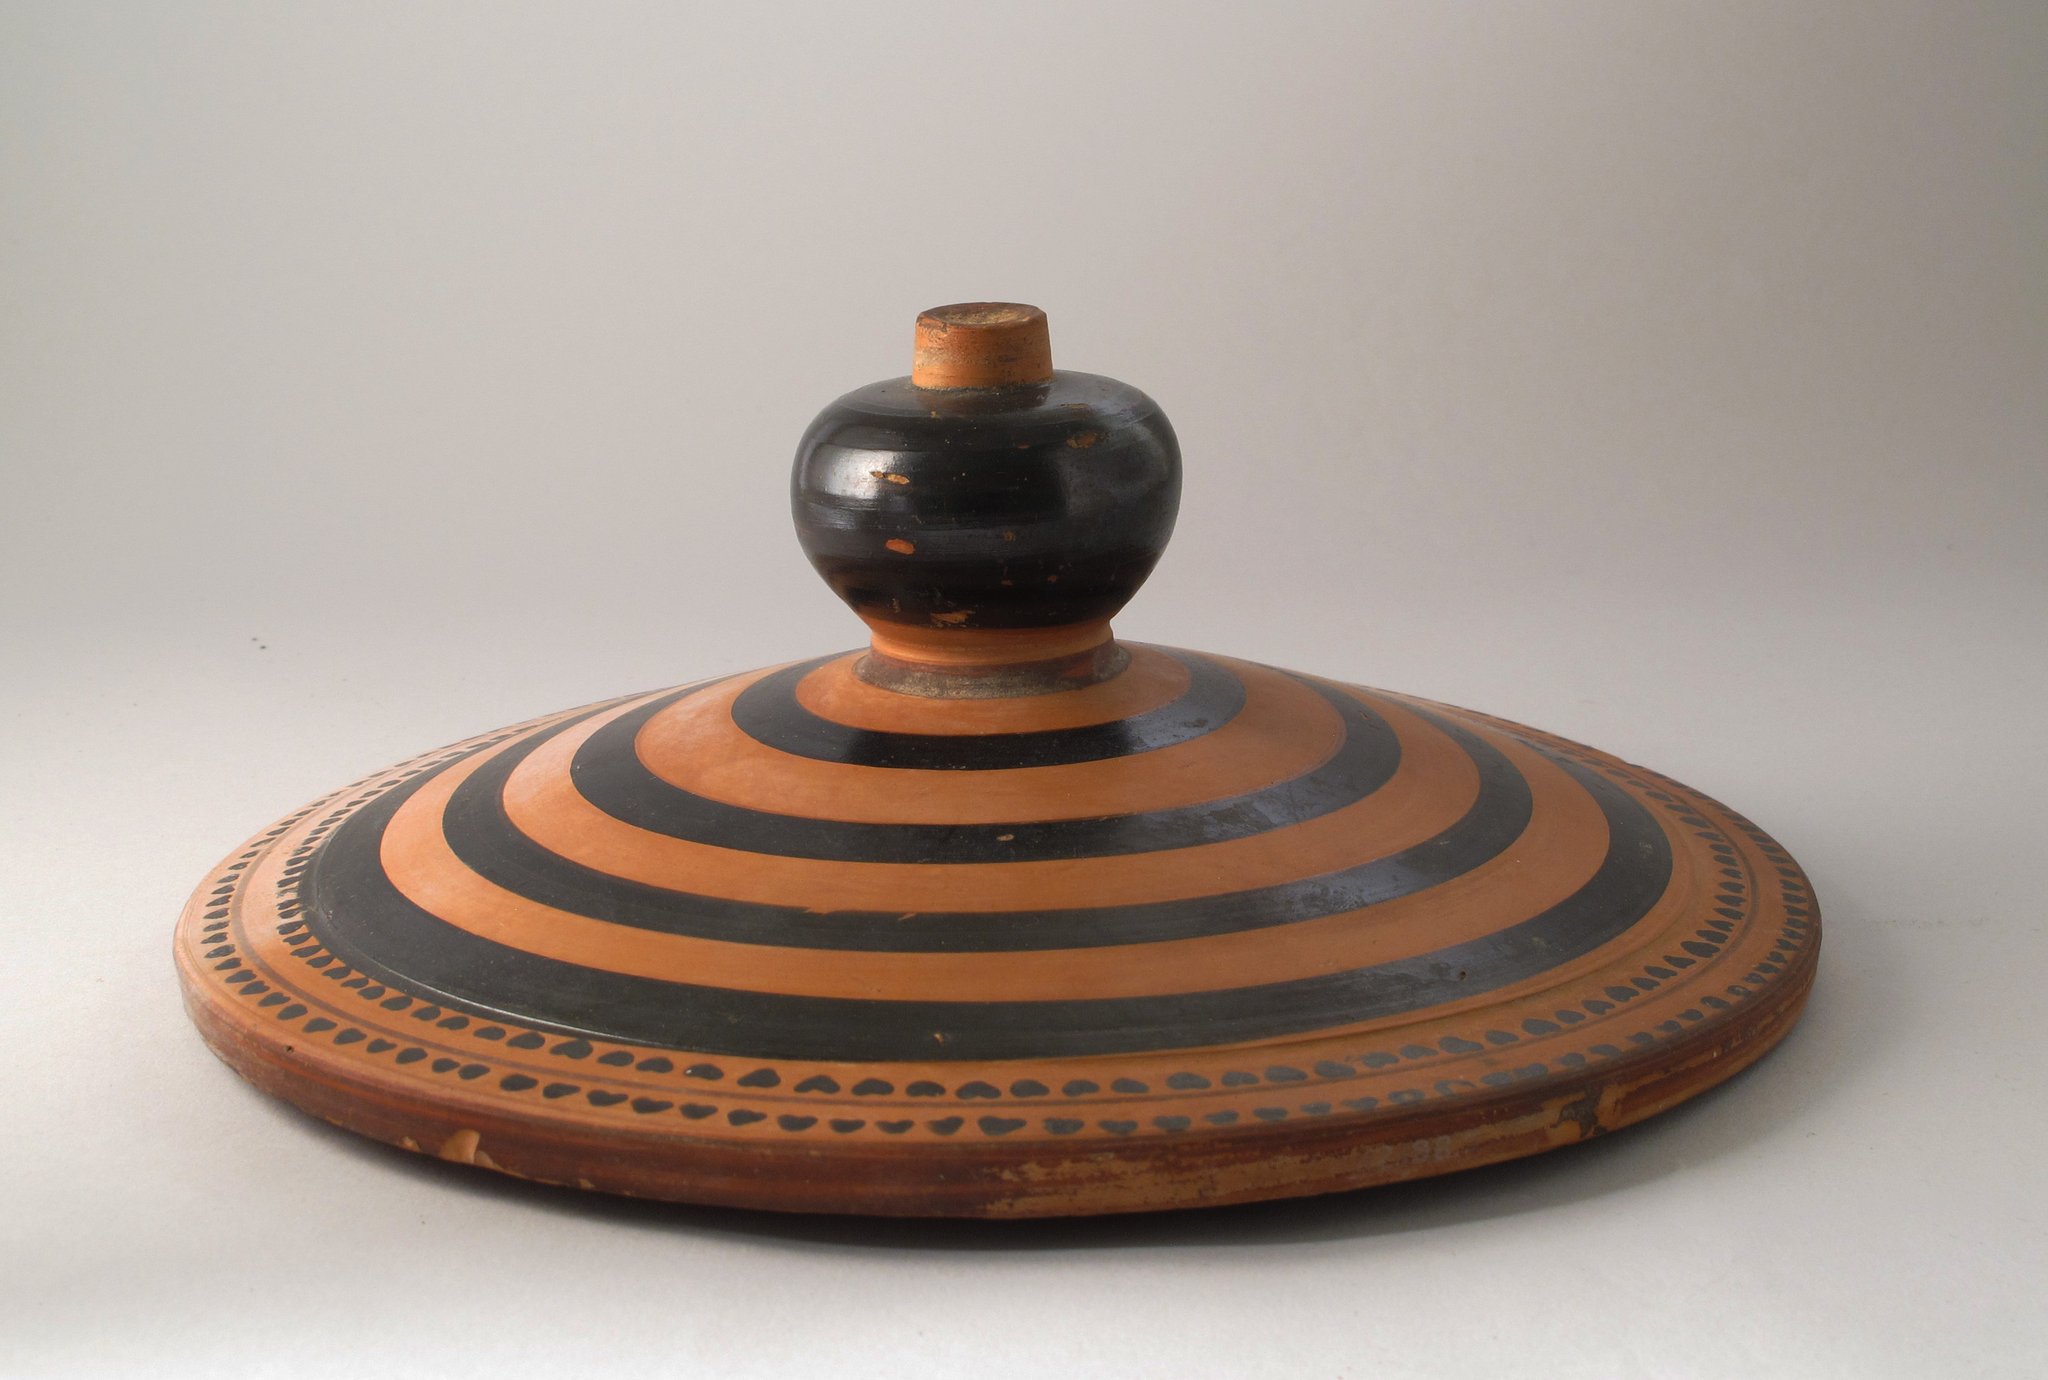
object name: neck amphora with lid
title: Lid of a neck-amphora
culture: greek, attic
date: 600-501 BCE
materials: terracotta